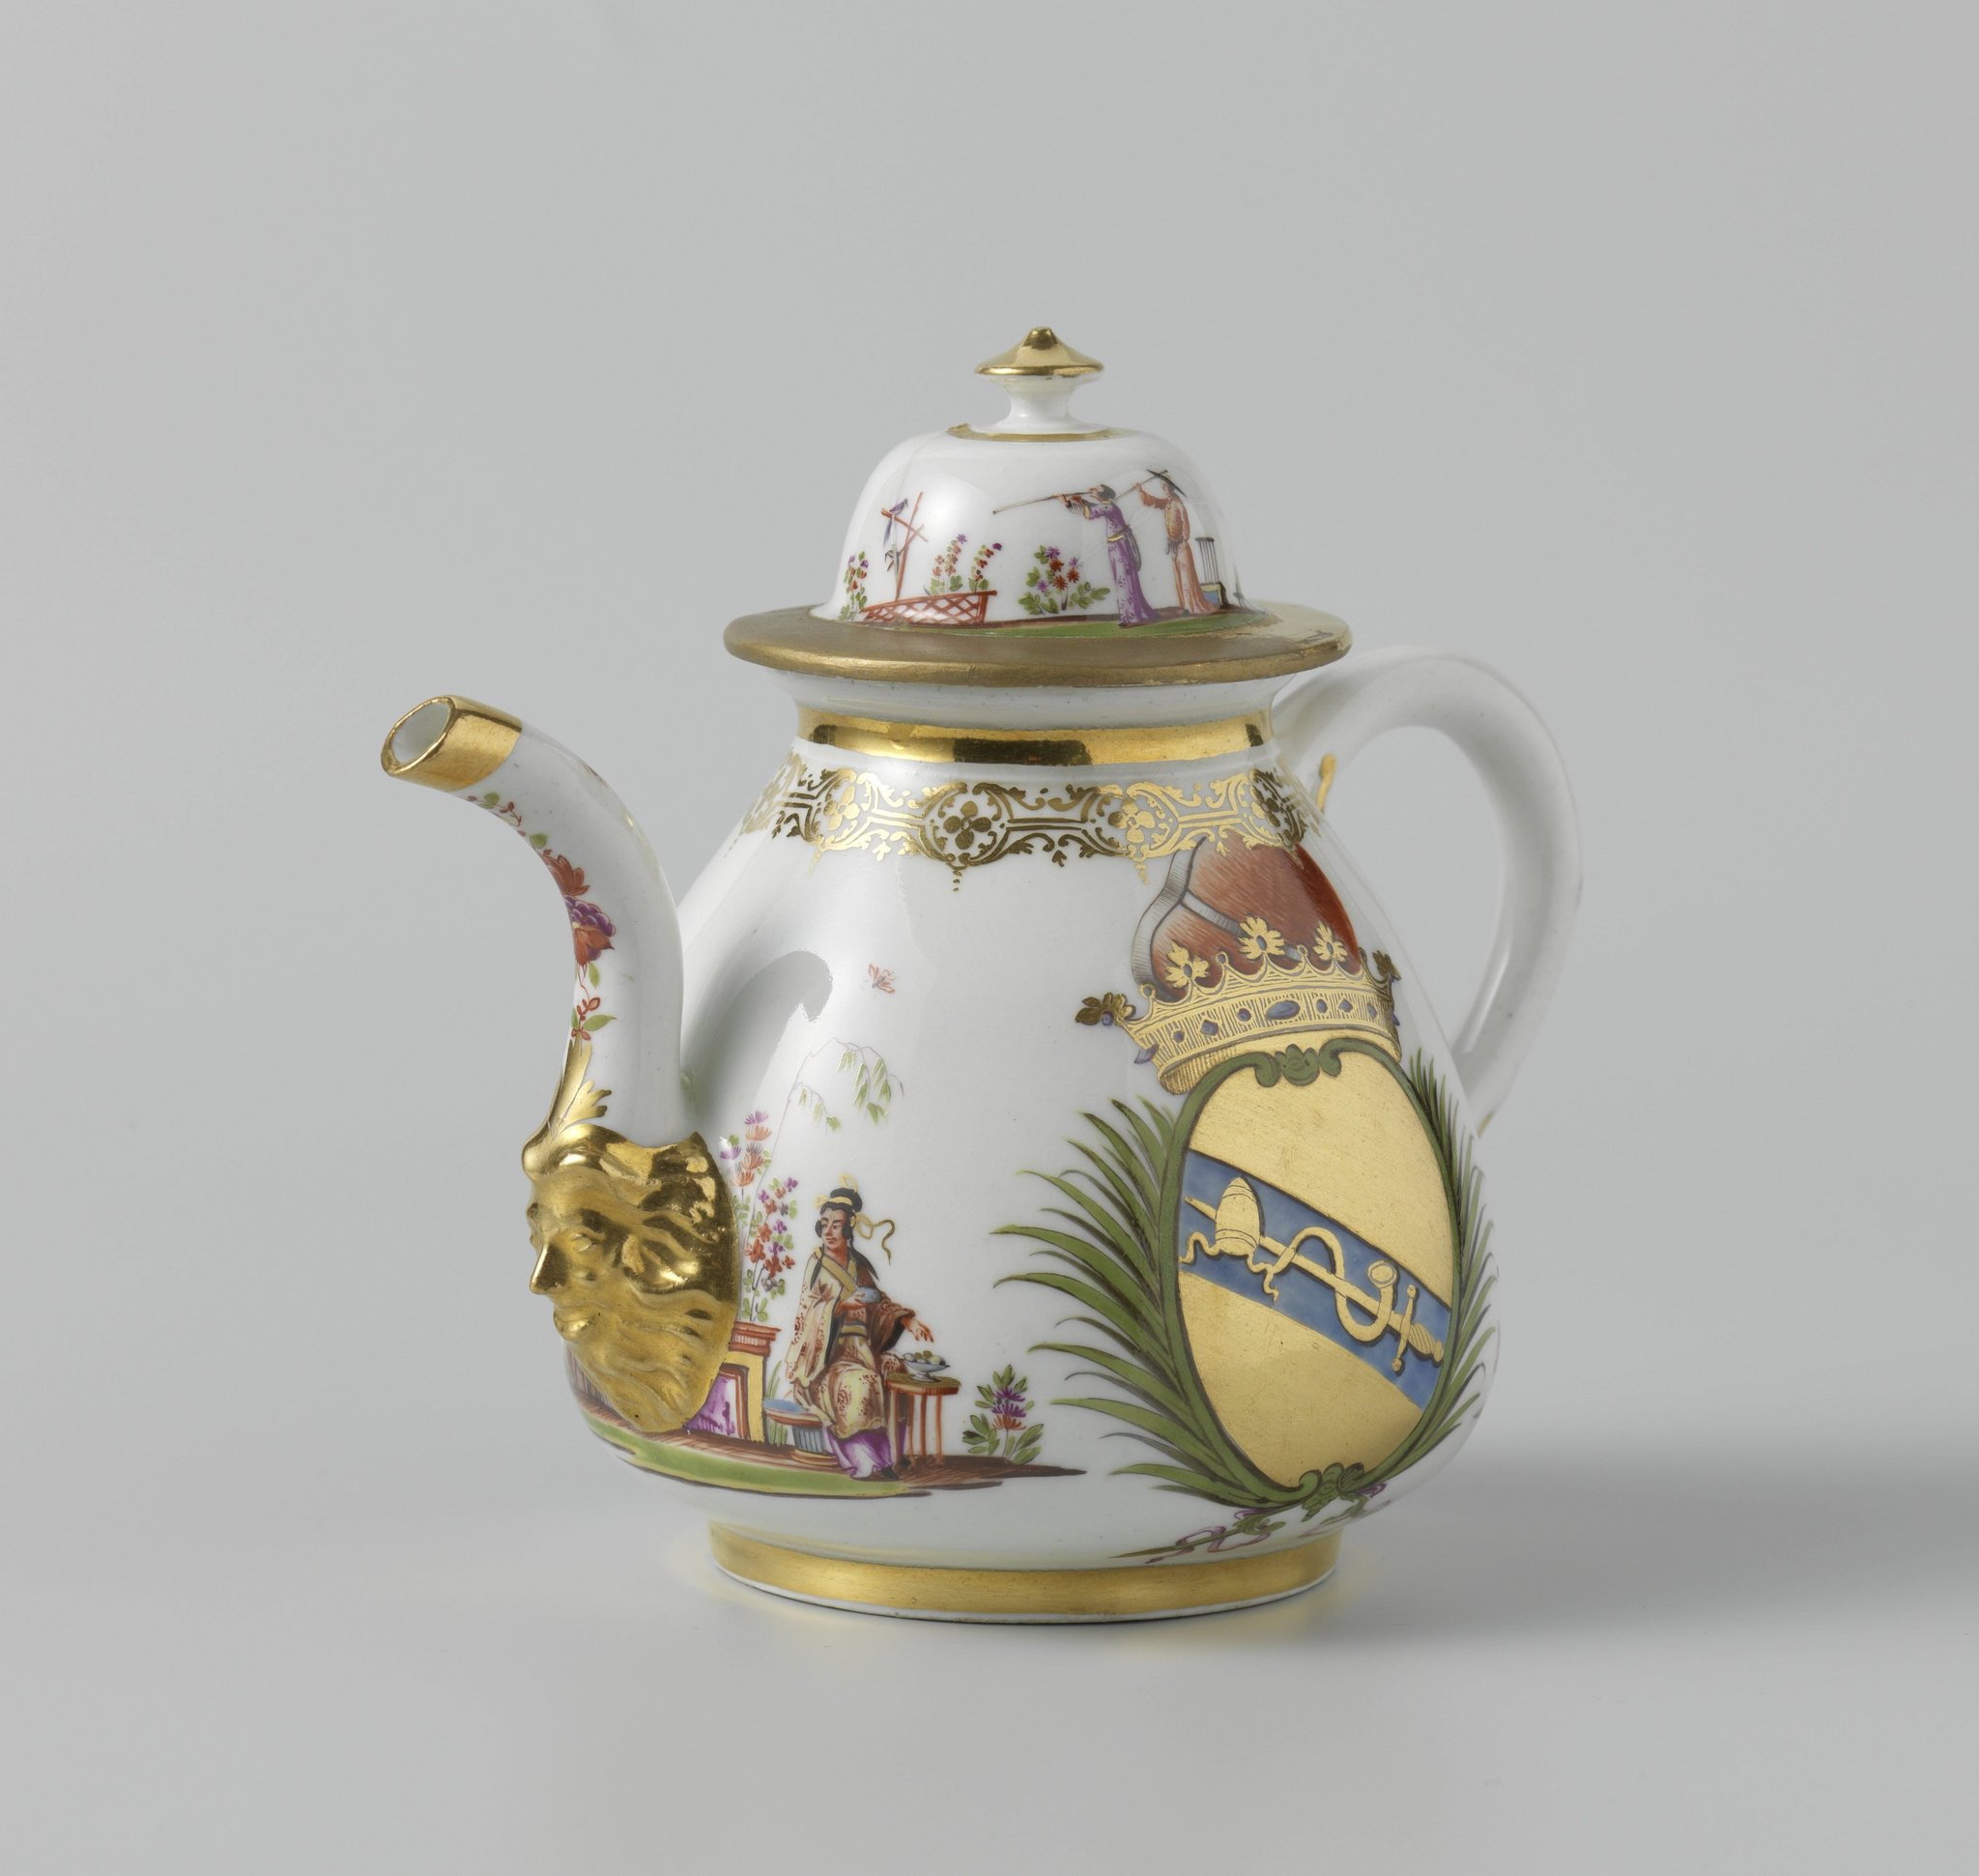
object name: teapot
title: Theepot met deksel, veelkleurig beschilderd met chinoiserieën en het wapen van de Venetiaanse familie Morosini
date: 1731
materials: porcelain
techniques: painted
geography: meissen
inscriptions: factory mark: ‘K.P.M’, number: ‘14’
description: Tea and coffee service with the arms of the Venetian ducal family Morosini. Porcelain in leather travelling case. Meissen, 1731, decorated in the style of Johann Gregorius Höroldt.